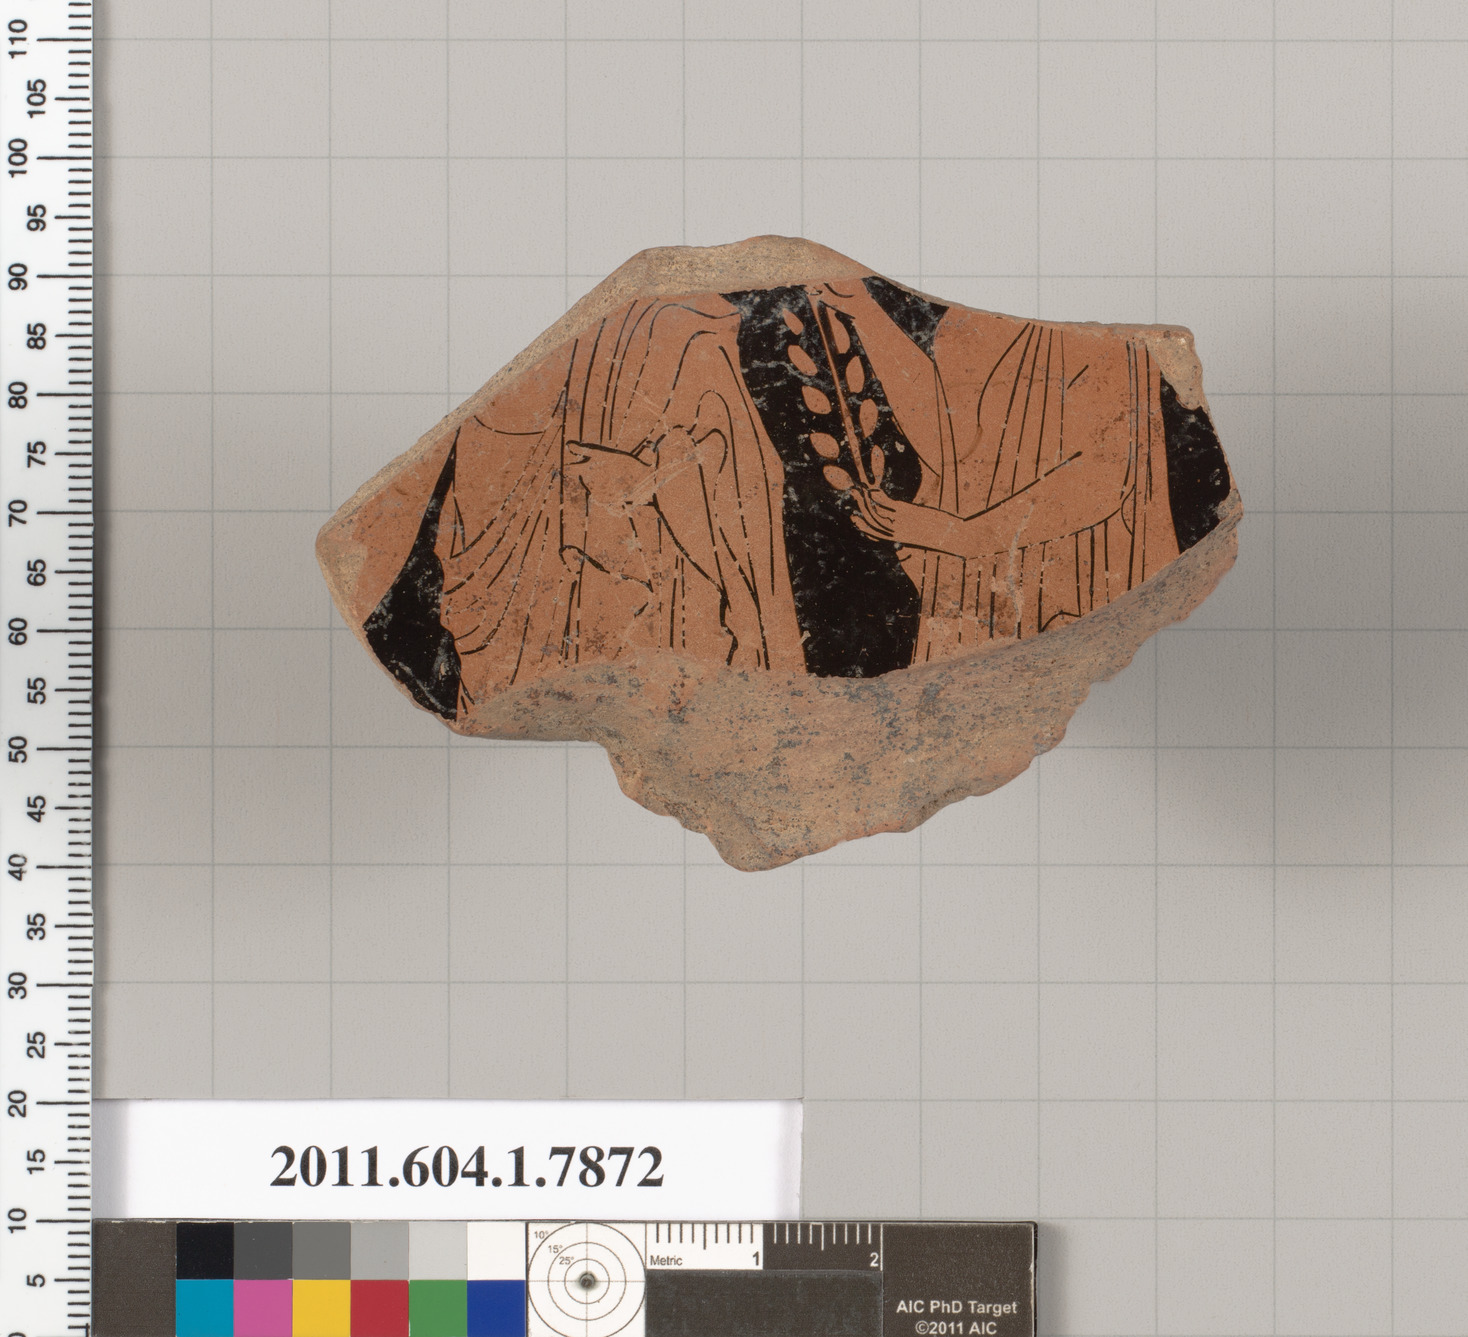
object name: kylix fragment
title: Terracotta fragment of a kylix (drinking cup)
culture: greek, attic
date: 440-420 BCE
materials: terracotta